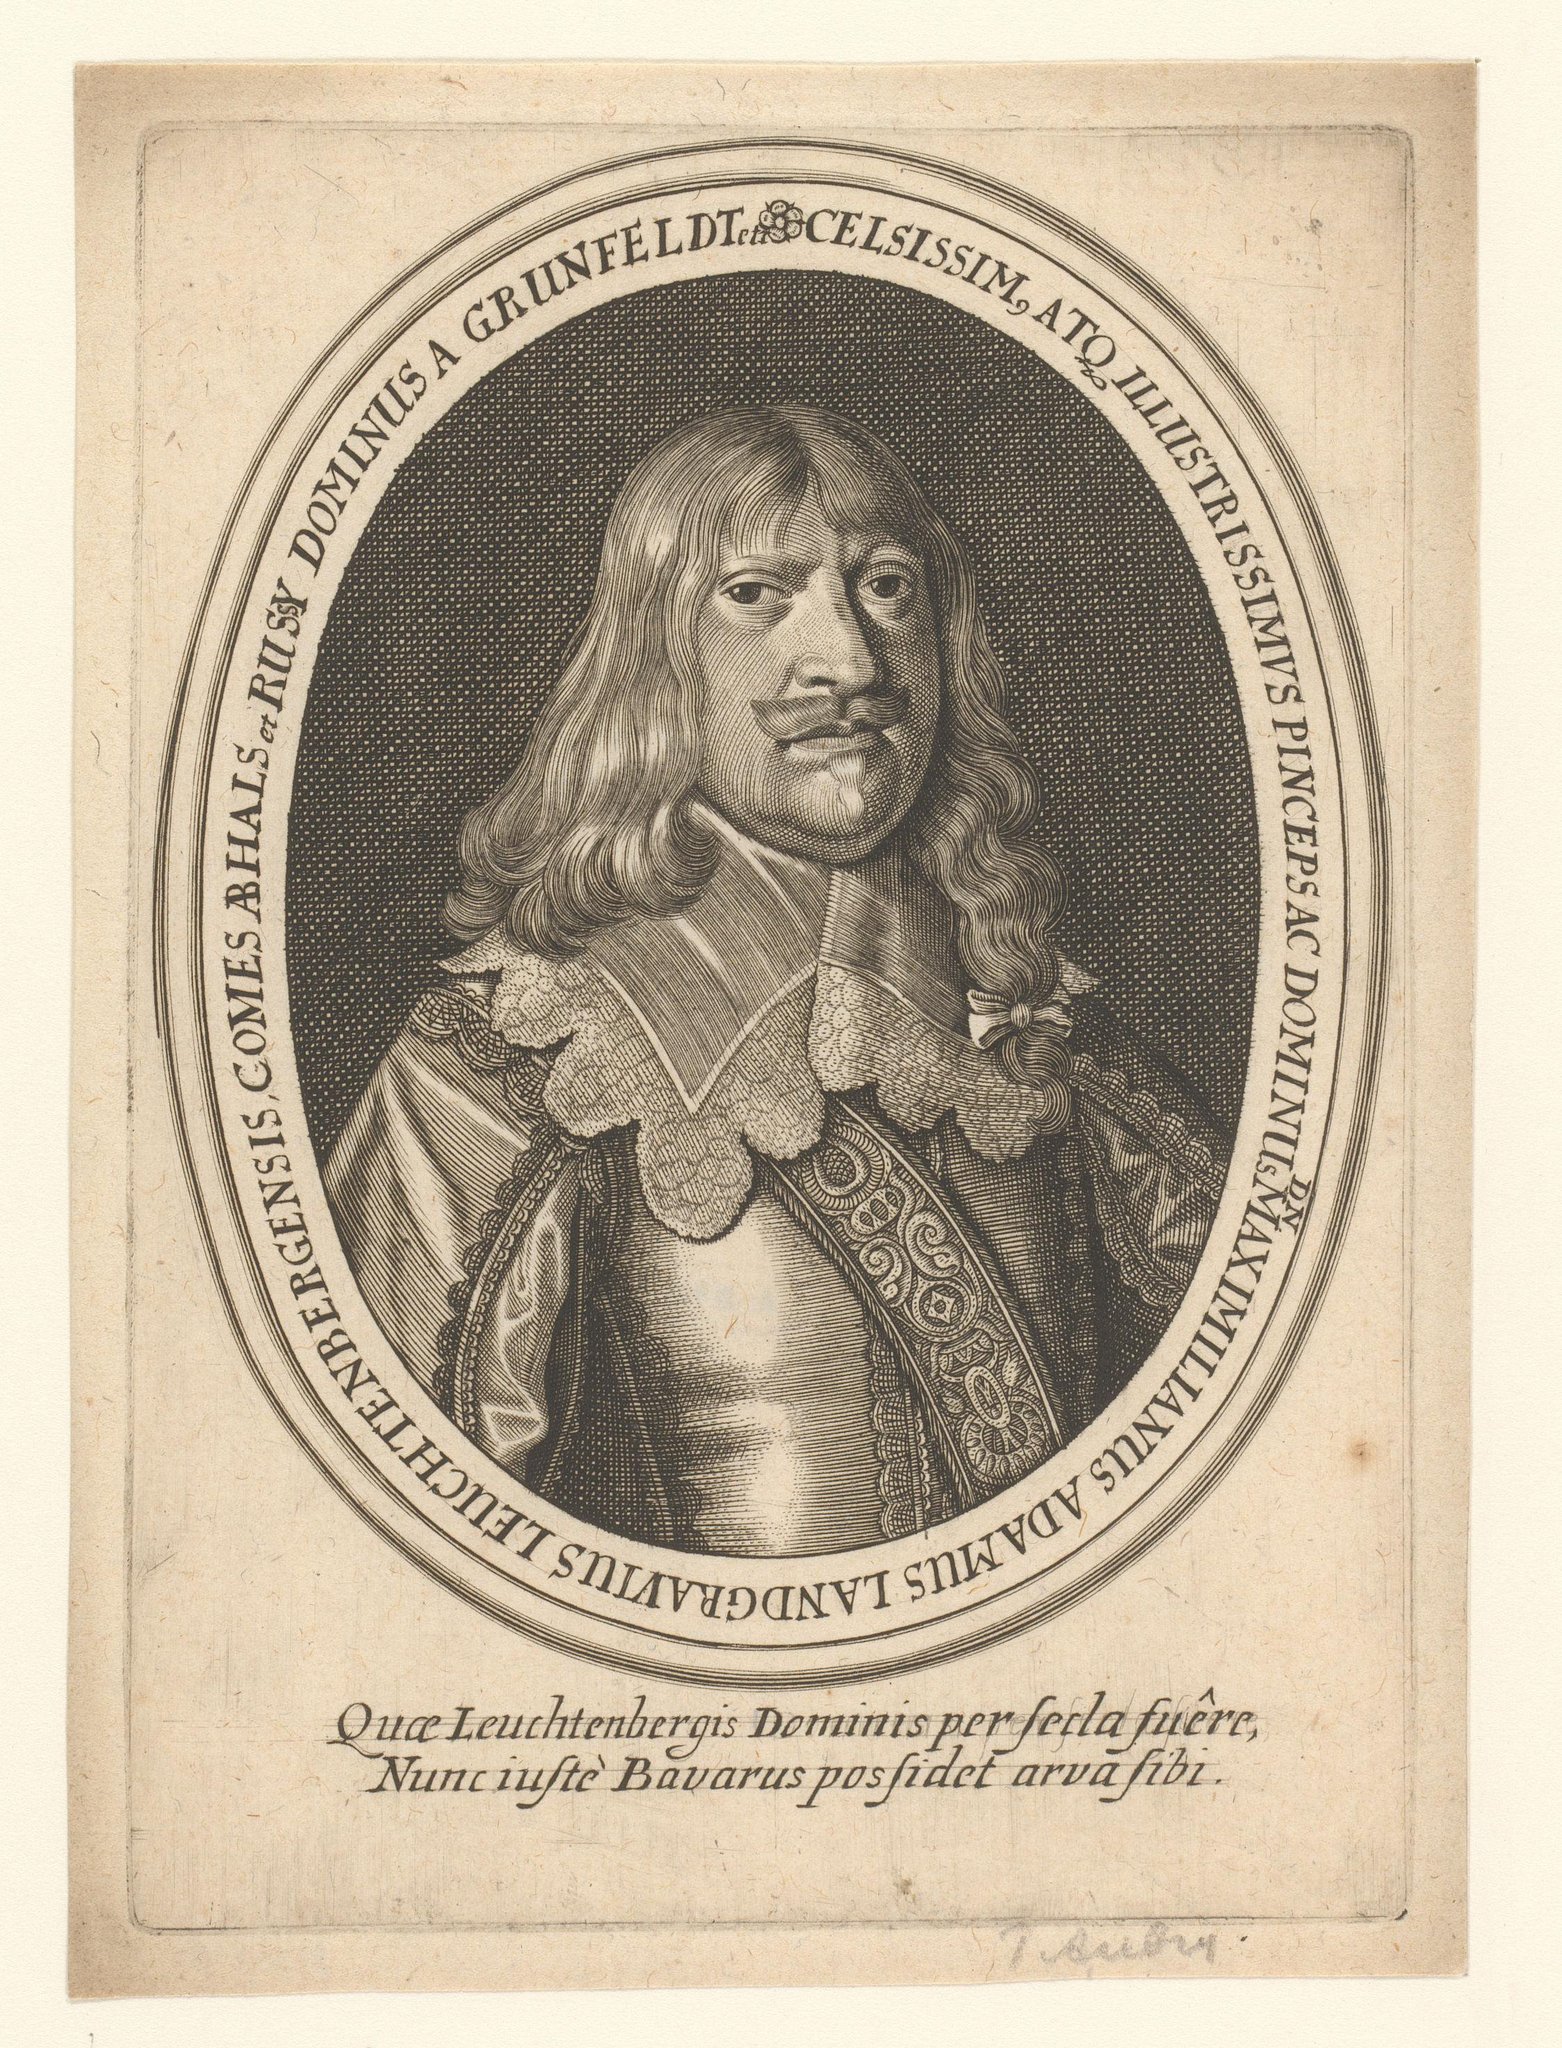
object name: print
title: Portret van Maximilian Adam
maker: Anonymous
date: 1621-1686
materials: paper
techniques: engraving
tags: provincial government, historical persons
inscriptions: collector's mark: Lugt 2228